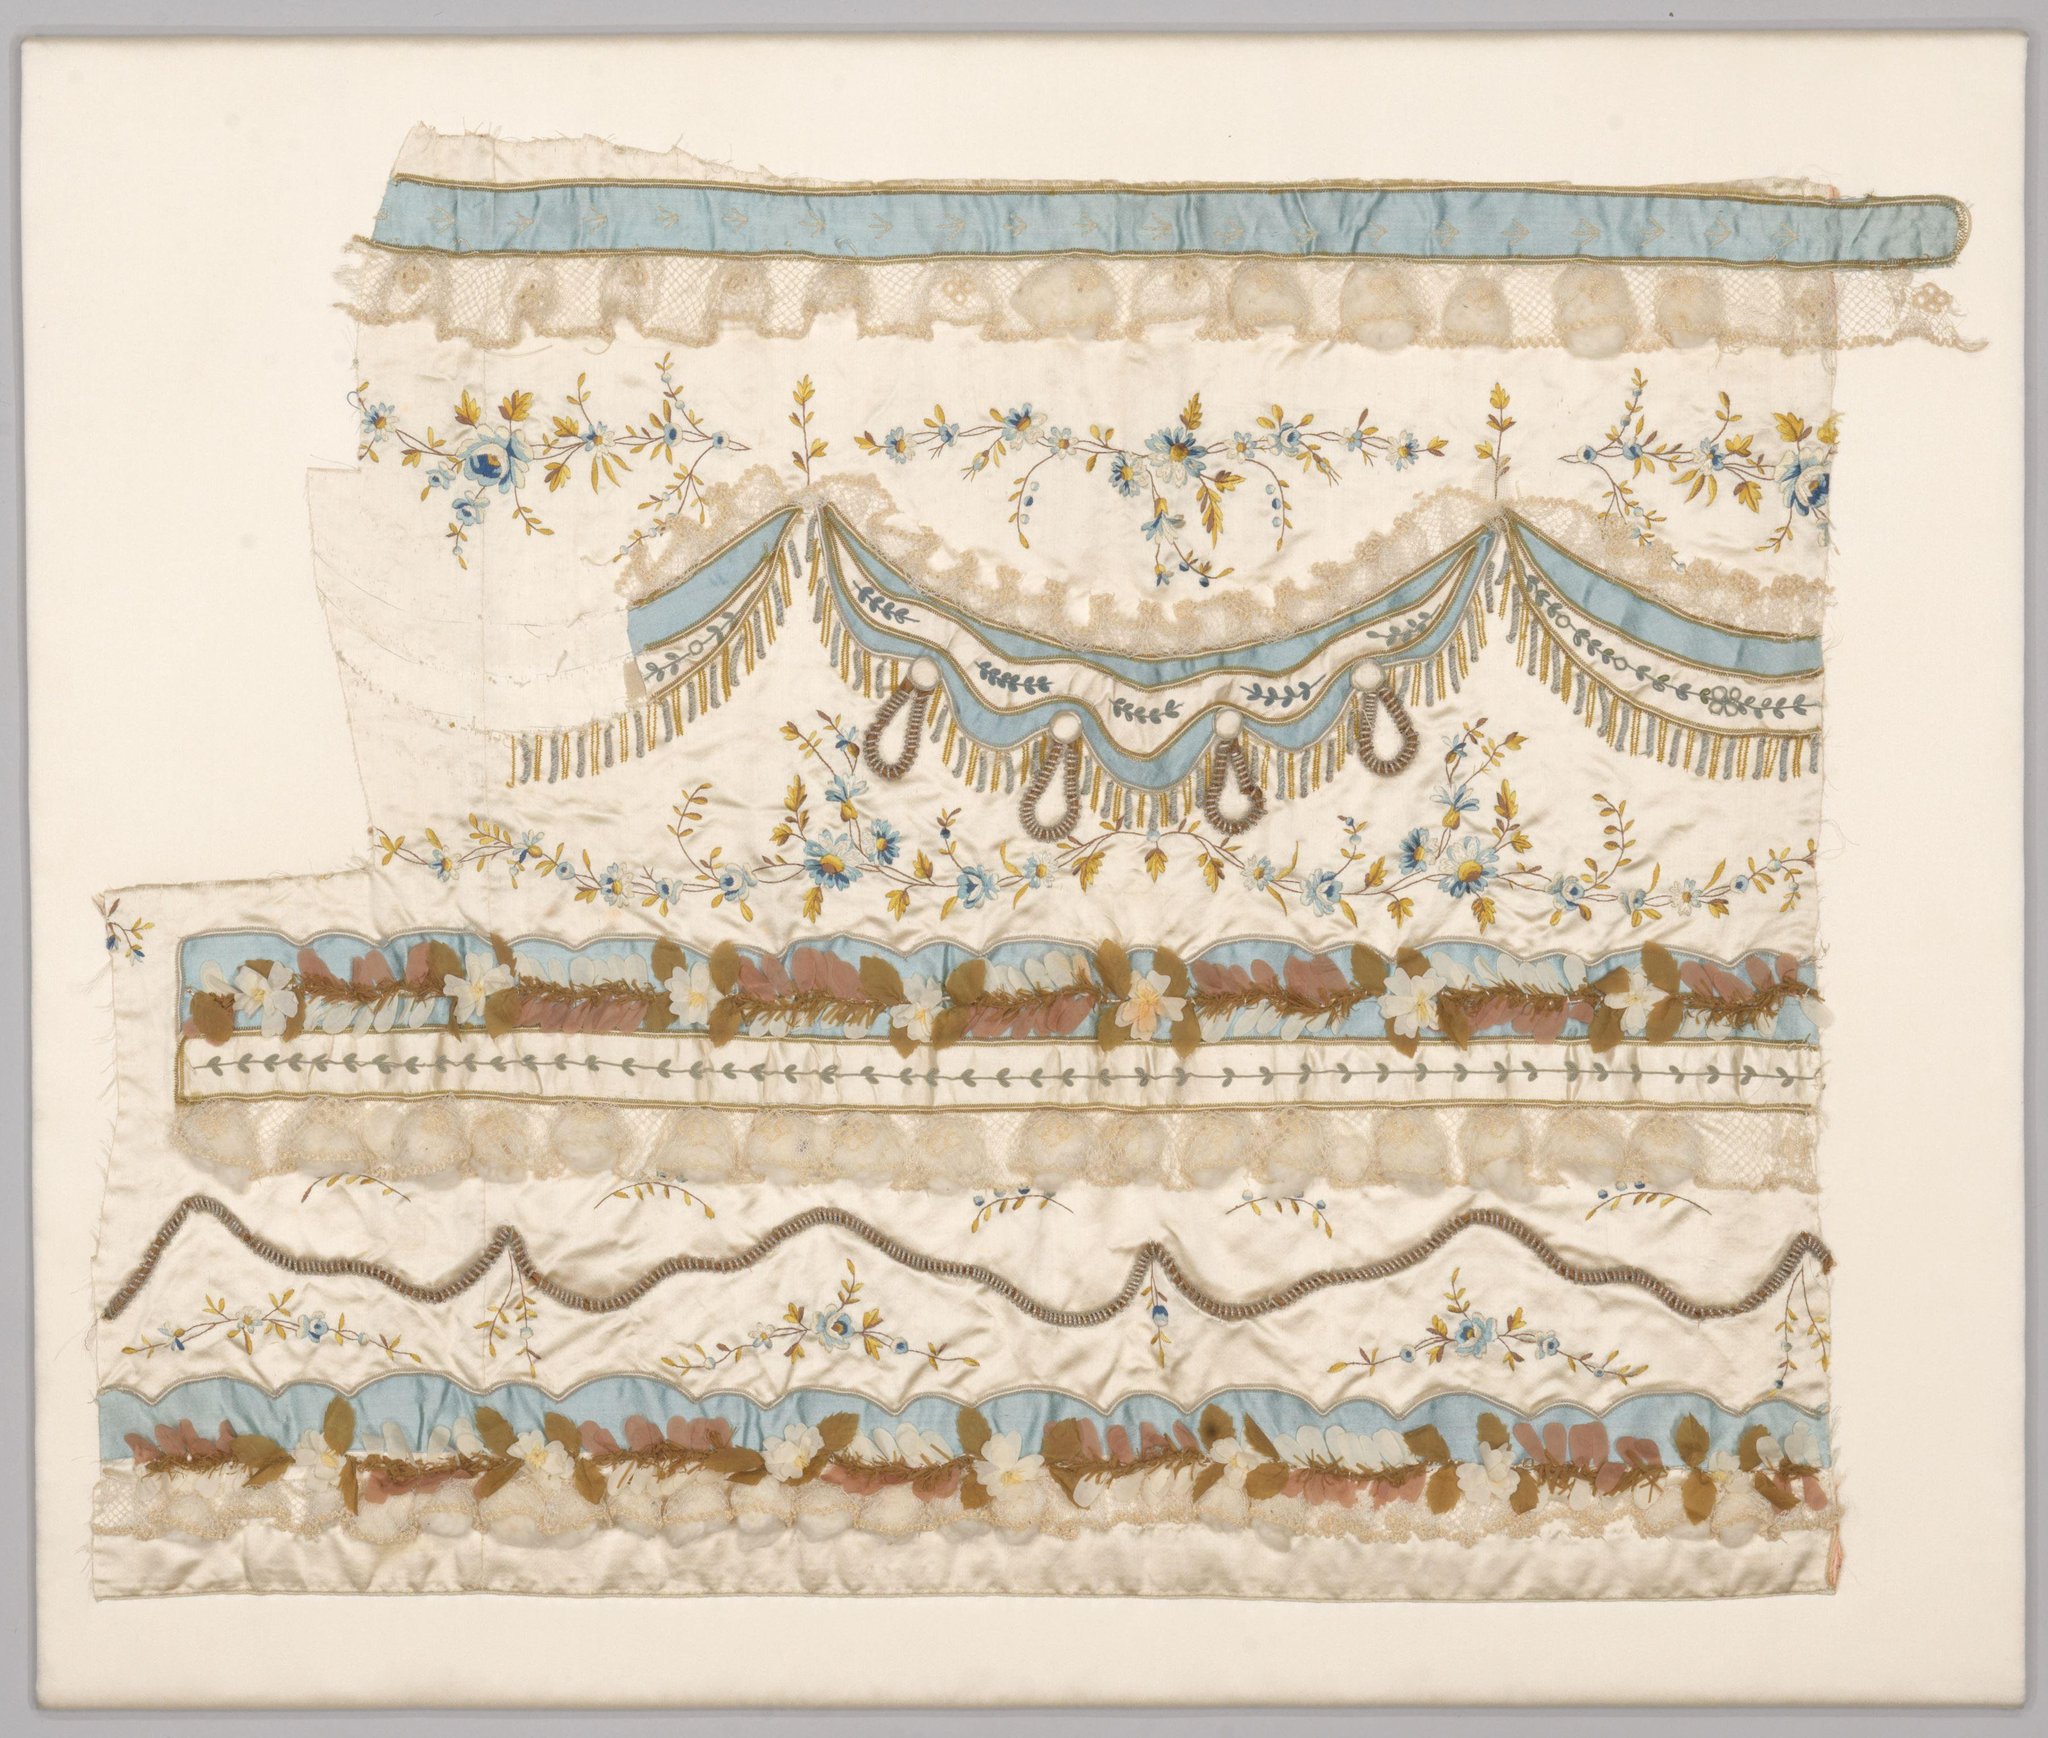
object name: lap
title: Lap van ivoorkleurig zijden satijn met borduursels en opnaaisels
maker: Anonymous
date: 1800-1900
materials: cotton, metal thread, silk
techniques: embroidered, weave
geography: europe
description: Fragment zijdeweefsel met borduurwerk en tule. Het fragment heeft een patroon van bloemranken, golvende lambrekijns met aangenaaide lussen, bladranken en banen met opgenaaide zijde tule. Op met zijde bedekte hardboard gezet.